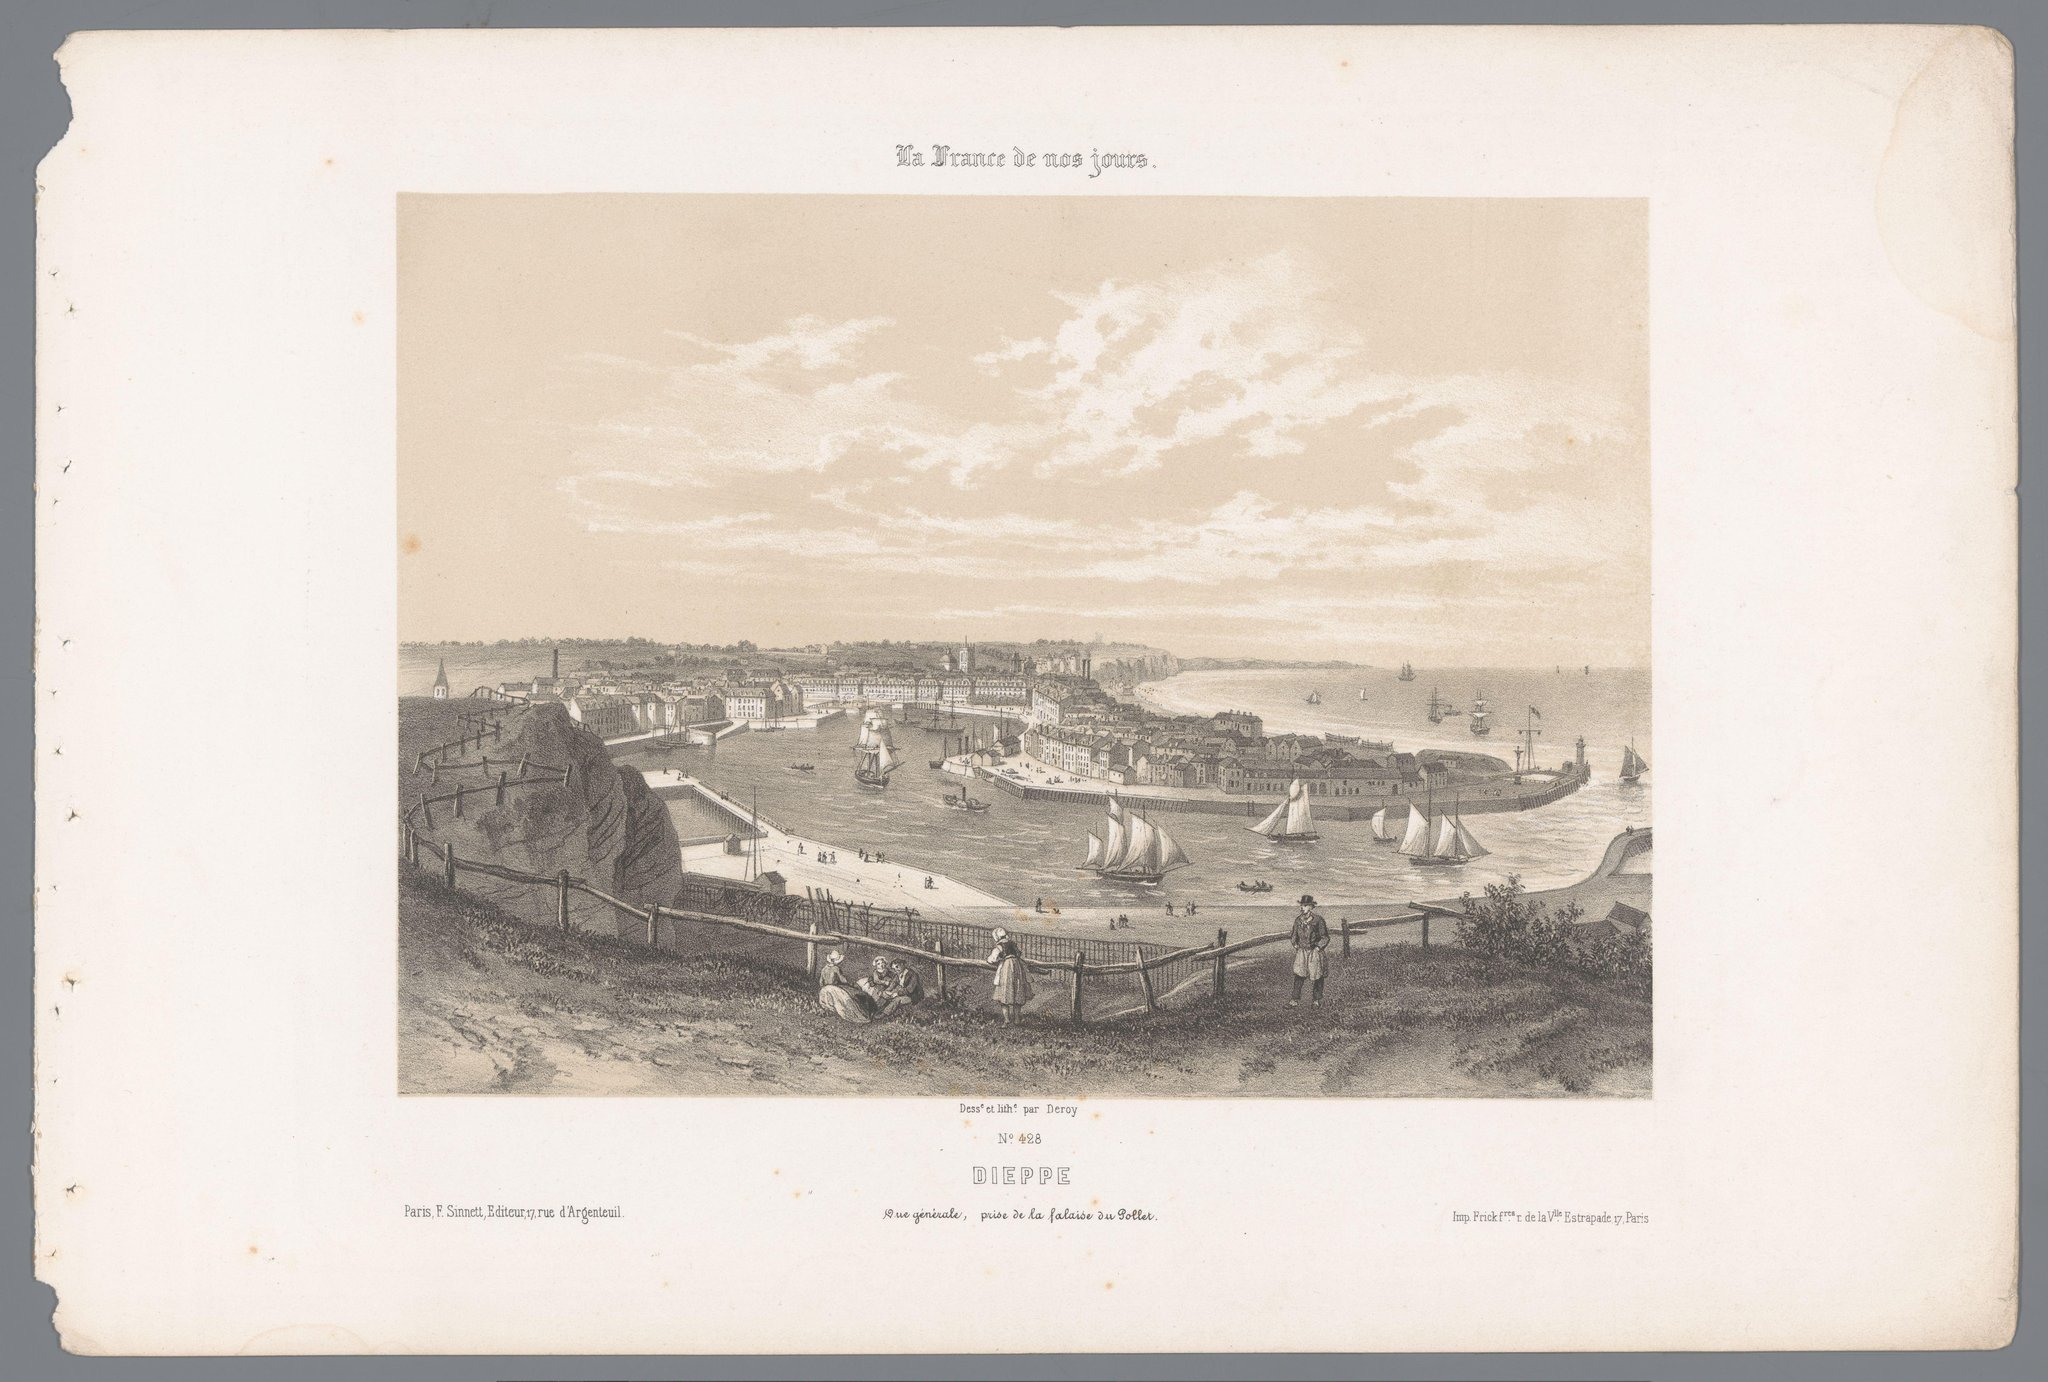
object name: print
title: Zicht op Dieppe vanaf de klif van Pollet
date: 1861-1872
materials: paper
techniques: tone lithography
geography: dieppe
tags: harbour, city-view in general; 'veduta', coastal cliff or crag (+ landscape with figures, staffage)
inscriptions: collector's mark: Lugt 2228a